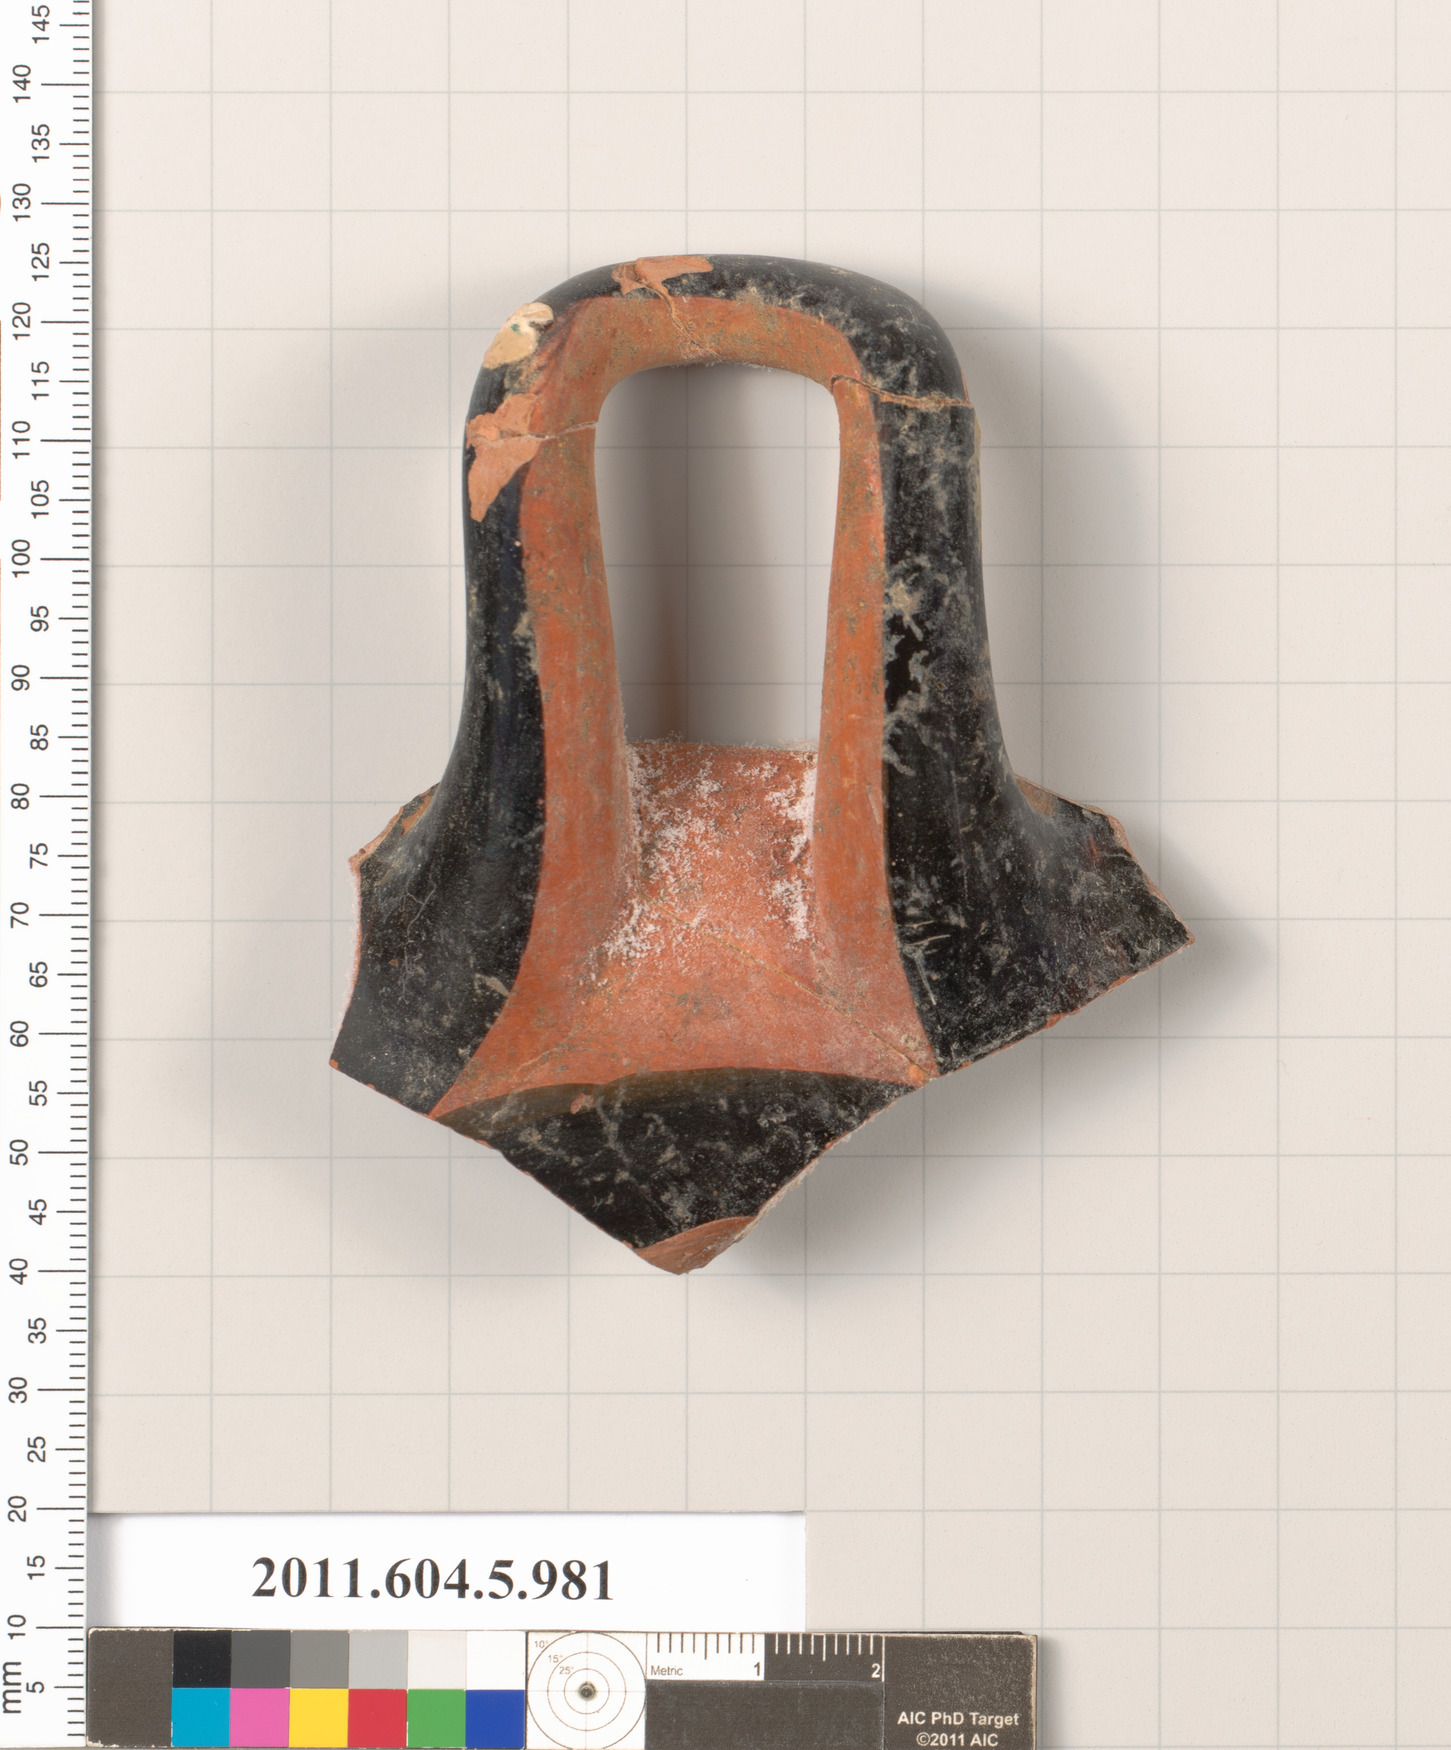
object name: kylix fragment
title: Terracotta fragment of a kylix (drinking cup)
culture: greek, attic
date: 600-401 BCE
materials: terracotta